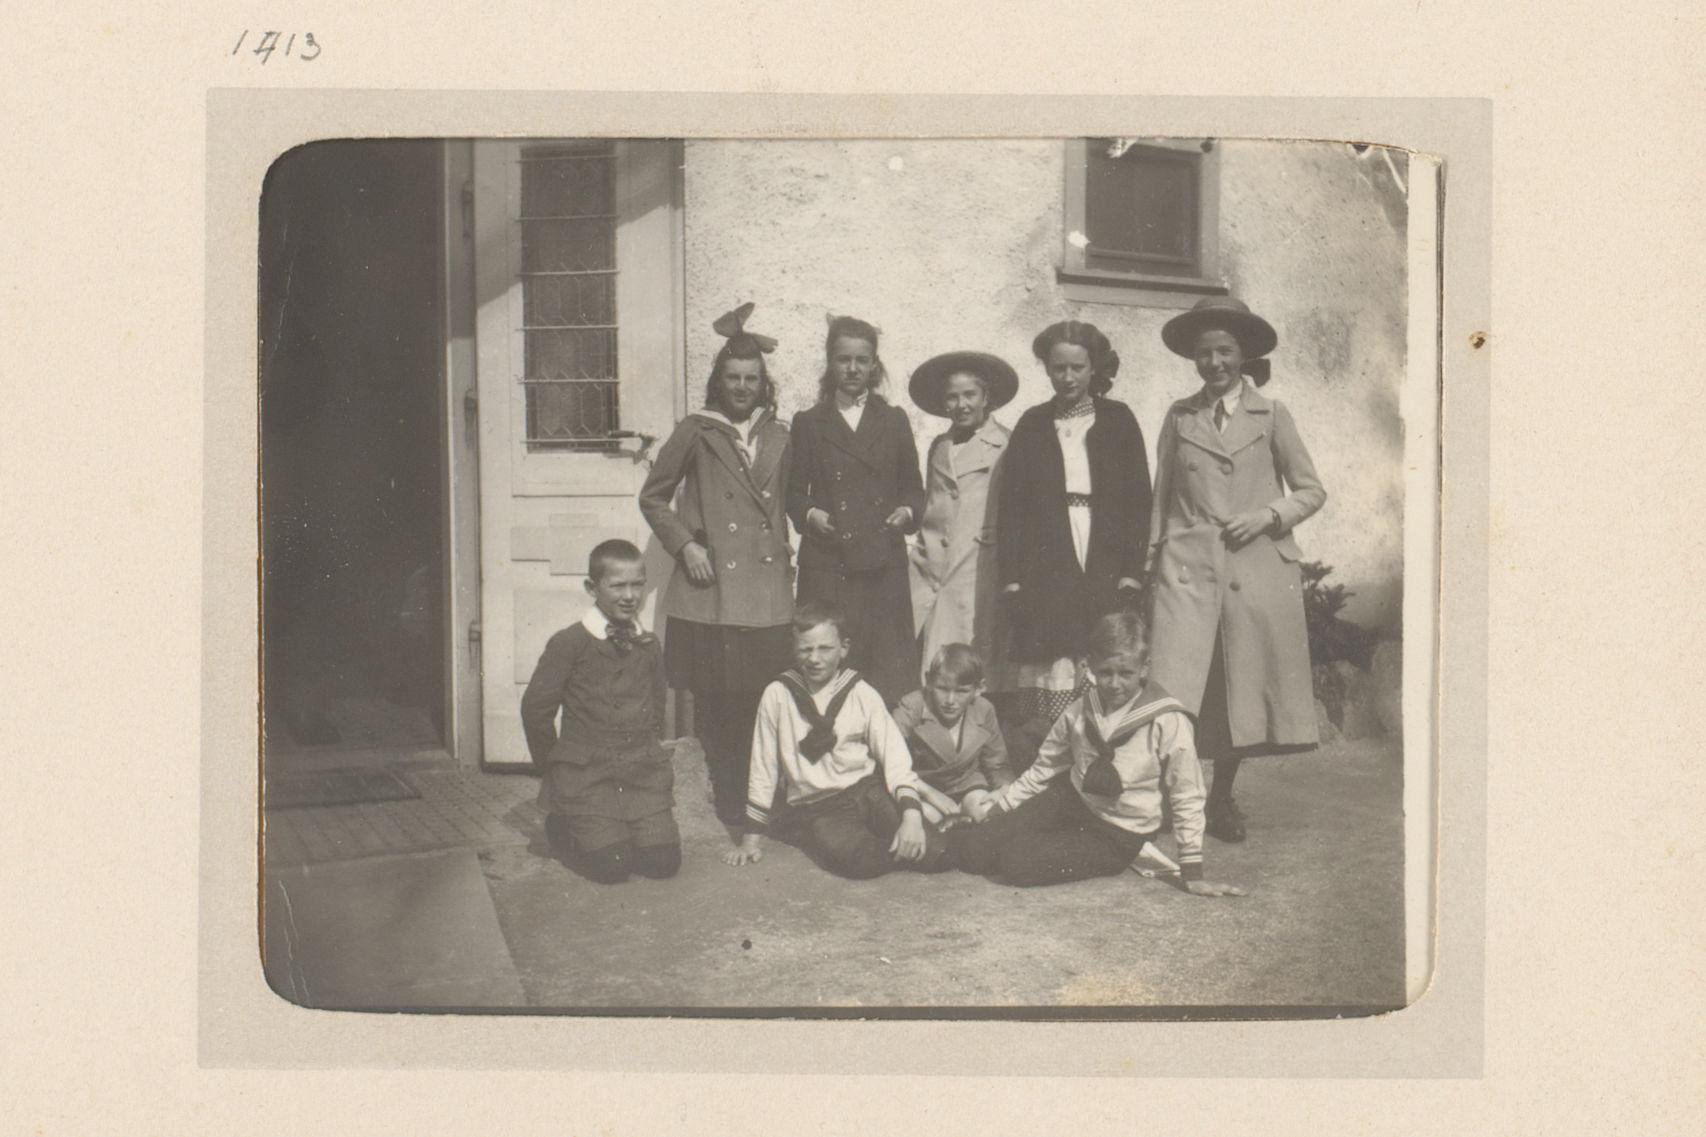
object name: photograph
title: Groepsportret van een gezelschap met kinderen en jongeren voor een gevel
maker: liesbeth overhoff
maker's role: fotograaf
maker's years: 1895-1969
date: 1913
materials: paper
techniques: gelatin silver print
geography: oberhof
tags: historical persons, automobile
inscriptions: inscription: ‘1913’